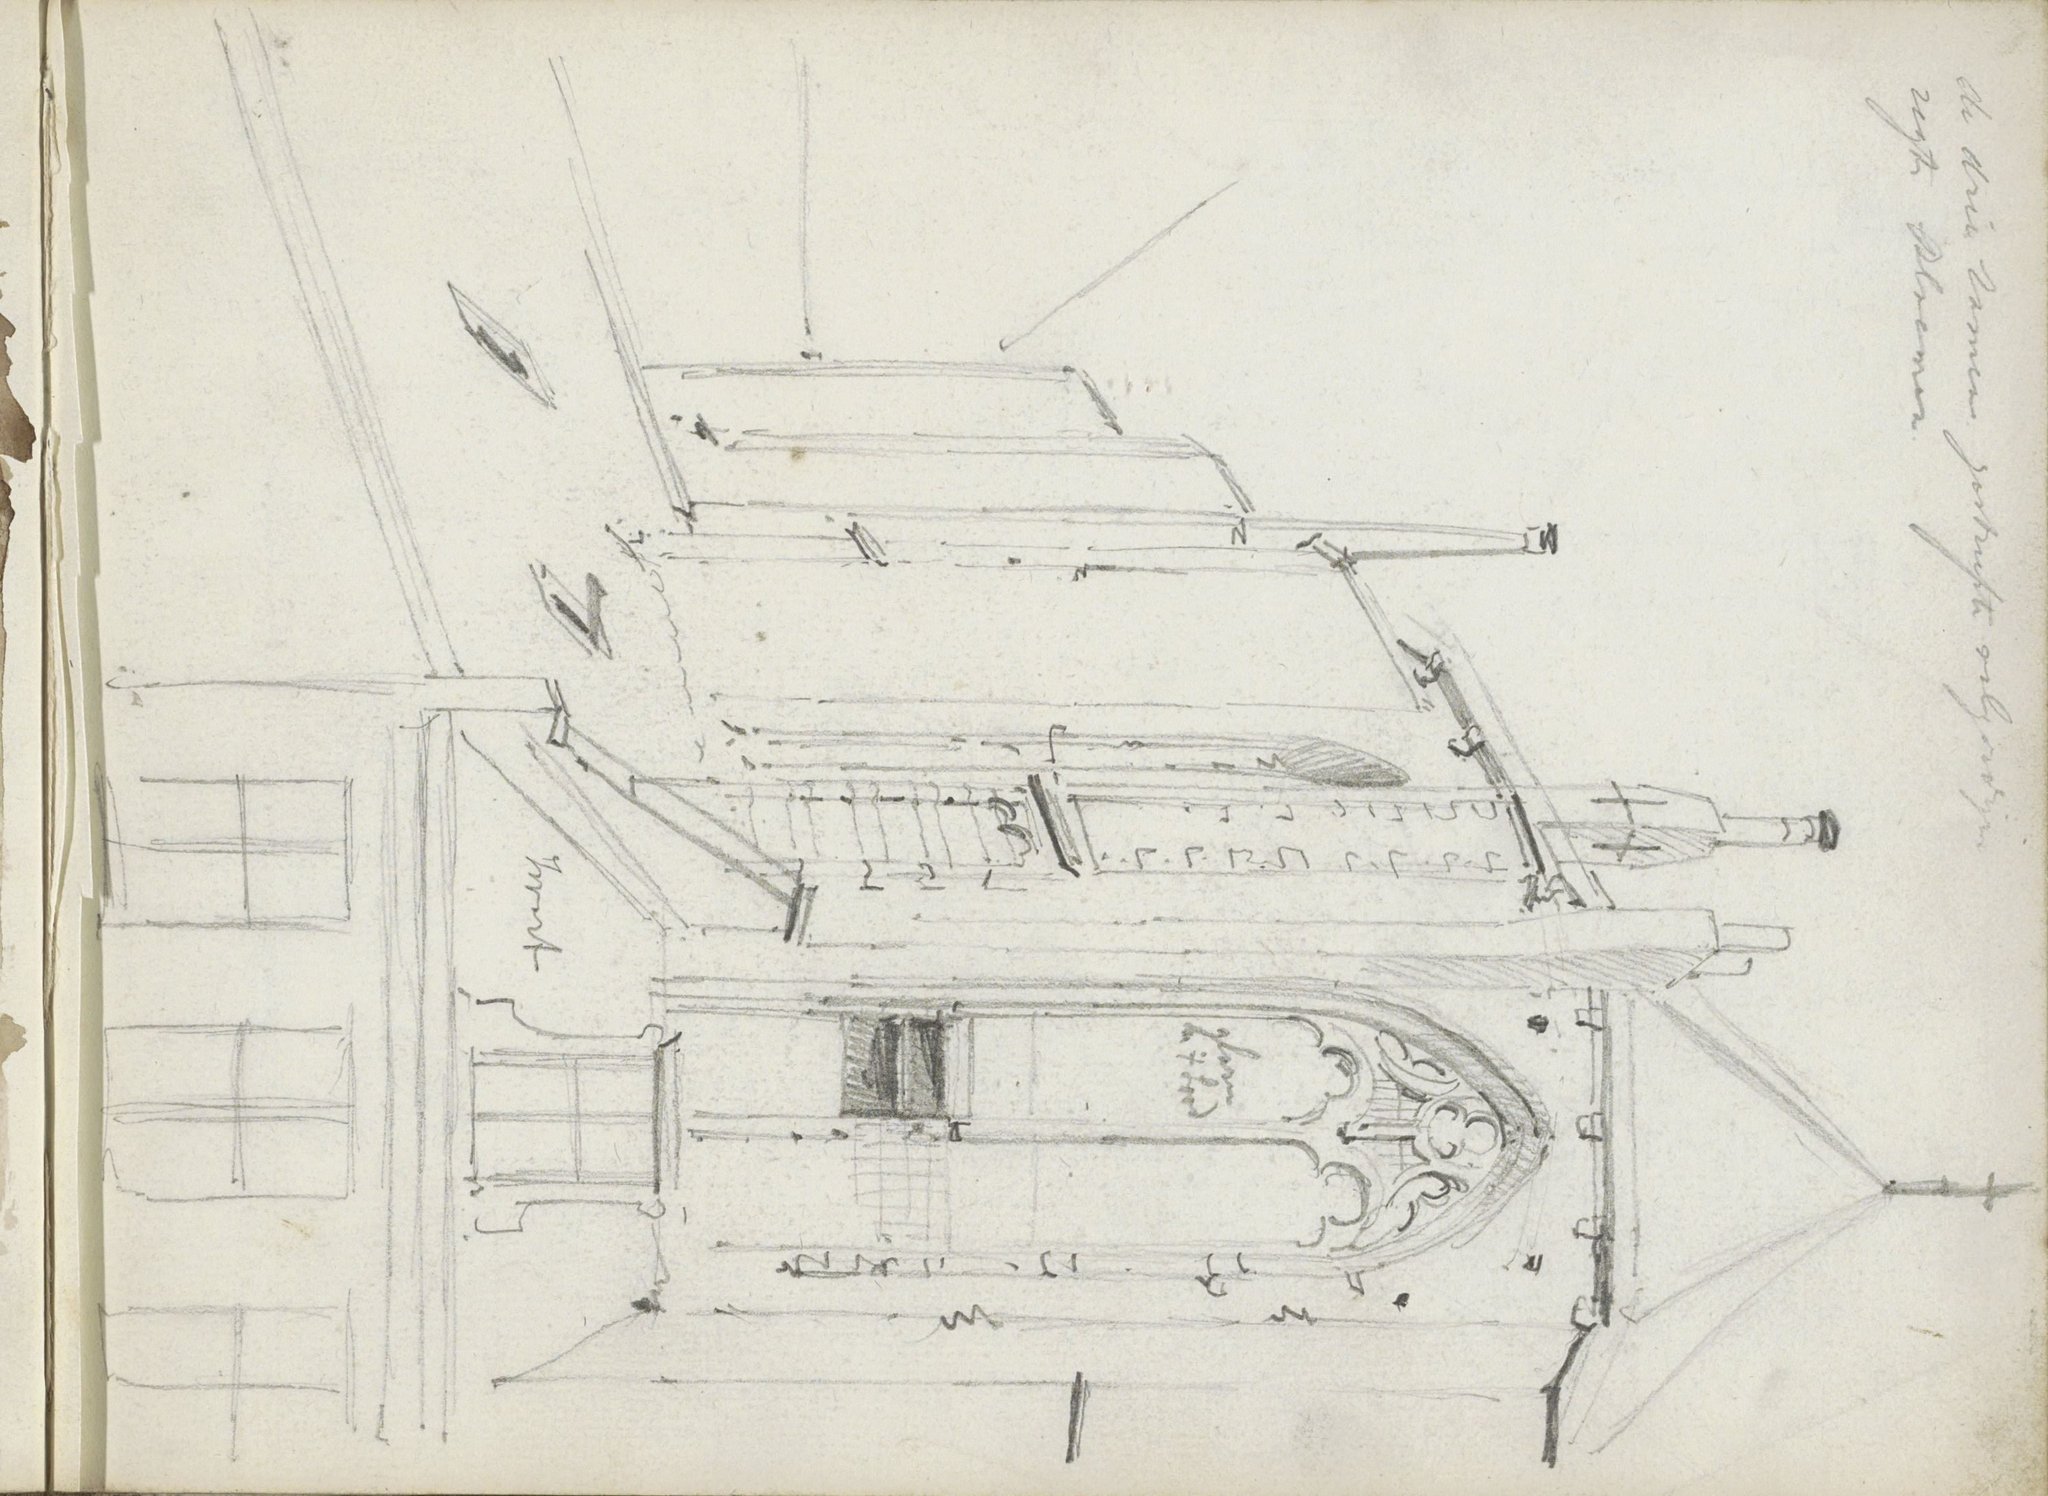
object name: sketchbook leaf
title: Exterieur van een kerk met maaswerk in de vensters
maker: willem koekkoek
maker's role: draughtsman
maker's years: 1839-1895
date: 1849-1895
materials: paper, pencil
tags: ornament ~ tracery, church (exterior)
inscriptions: annotation: ‘de drie ramen gestreepte valgordijn/ regter bloemen/ glas/ in 't lood’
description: Pagina 14 recto uit een schetsboek met 26 bladen.